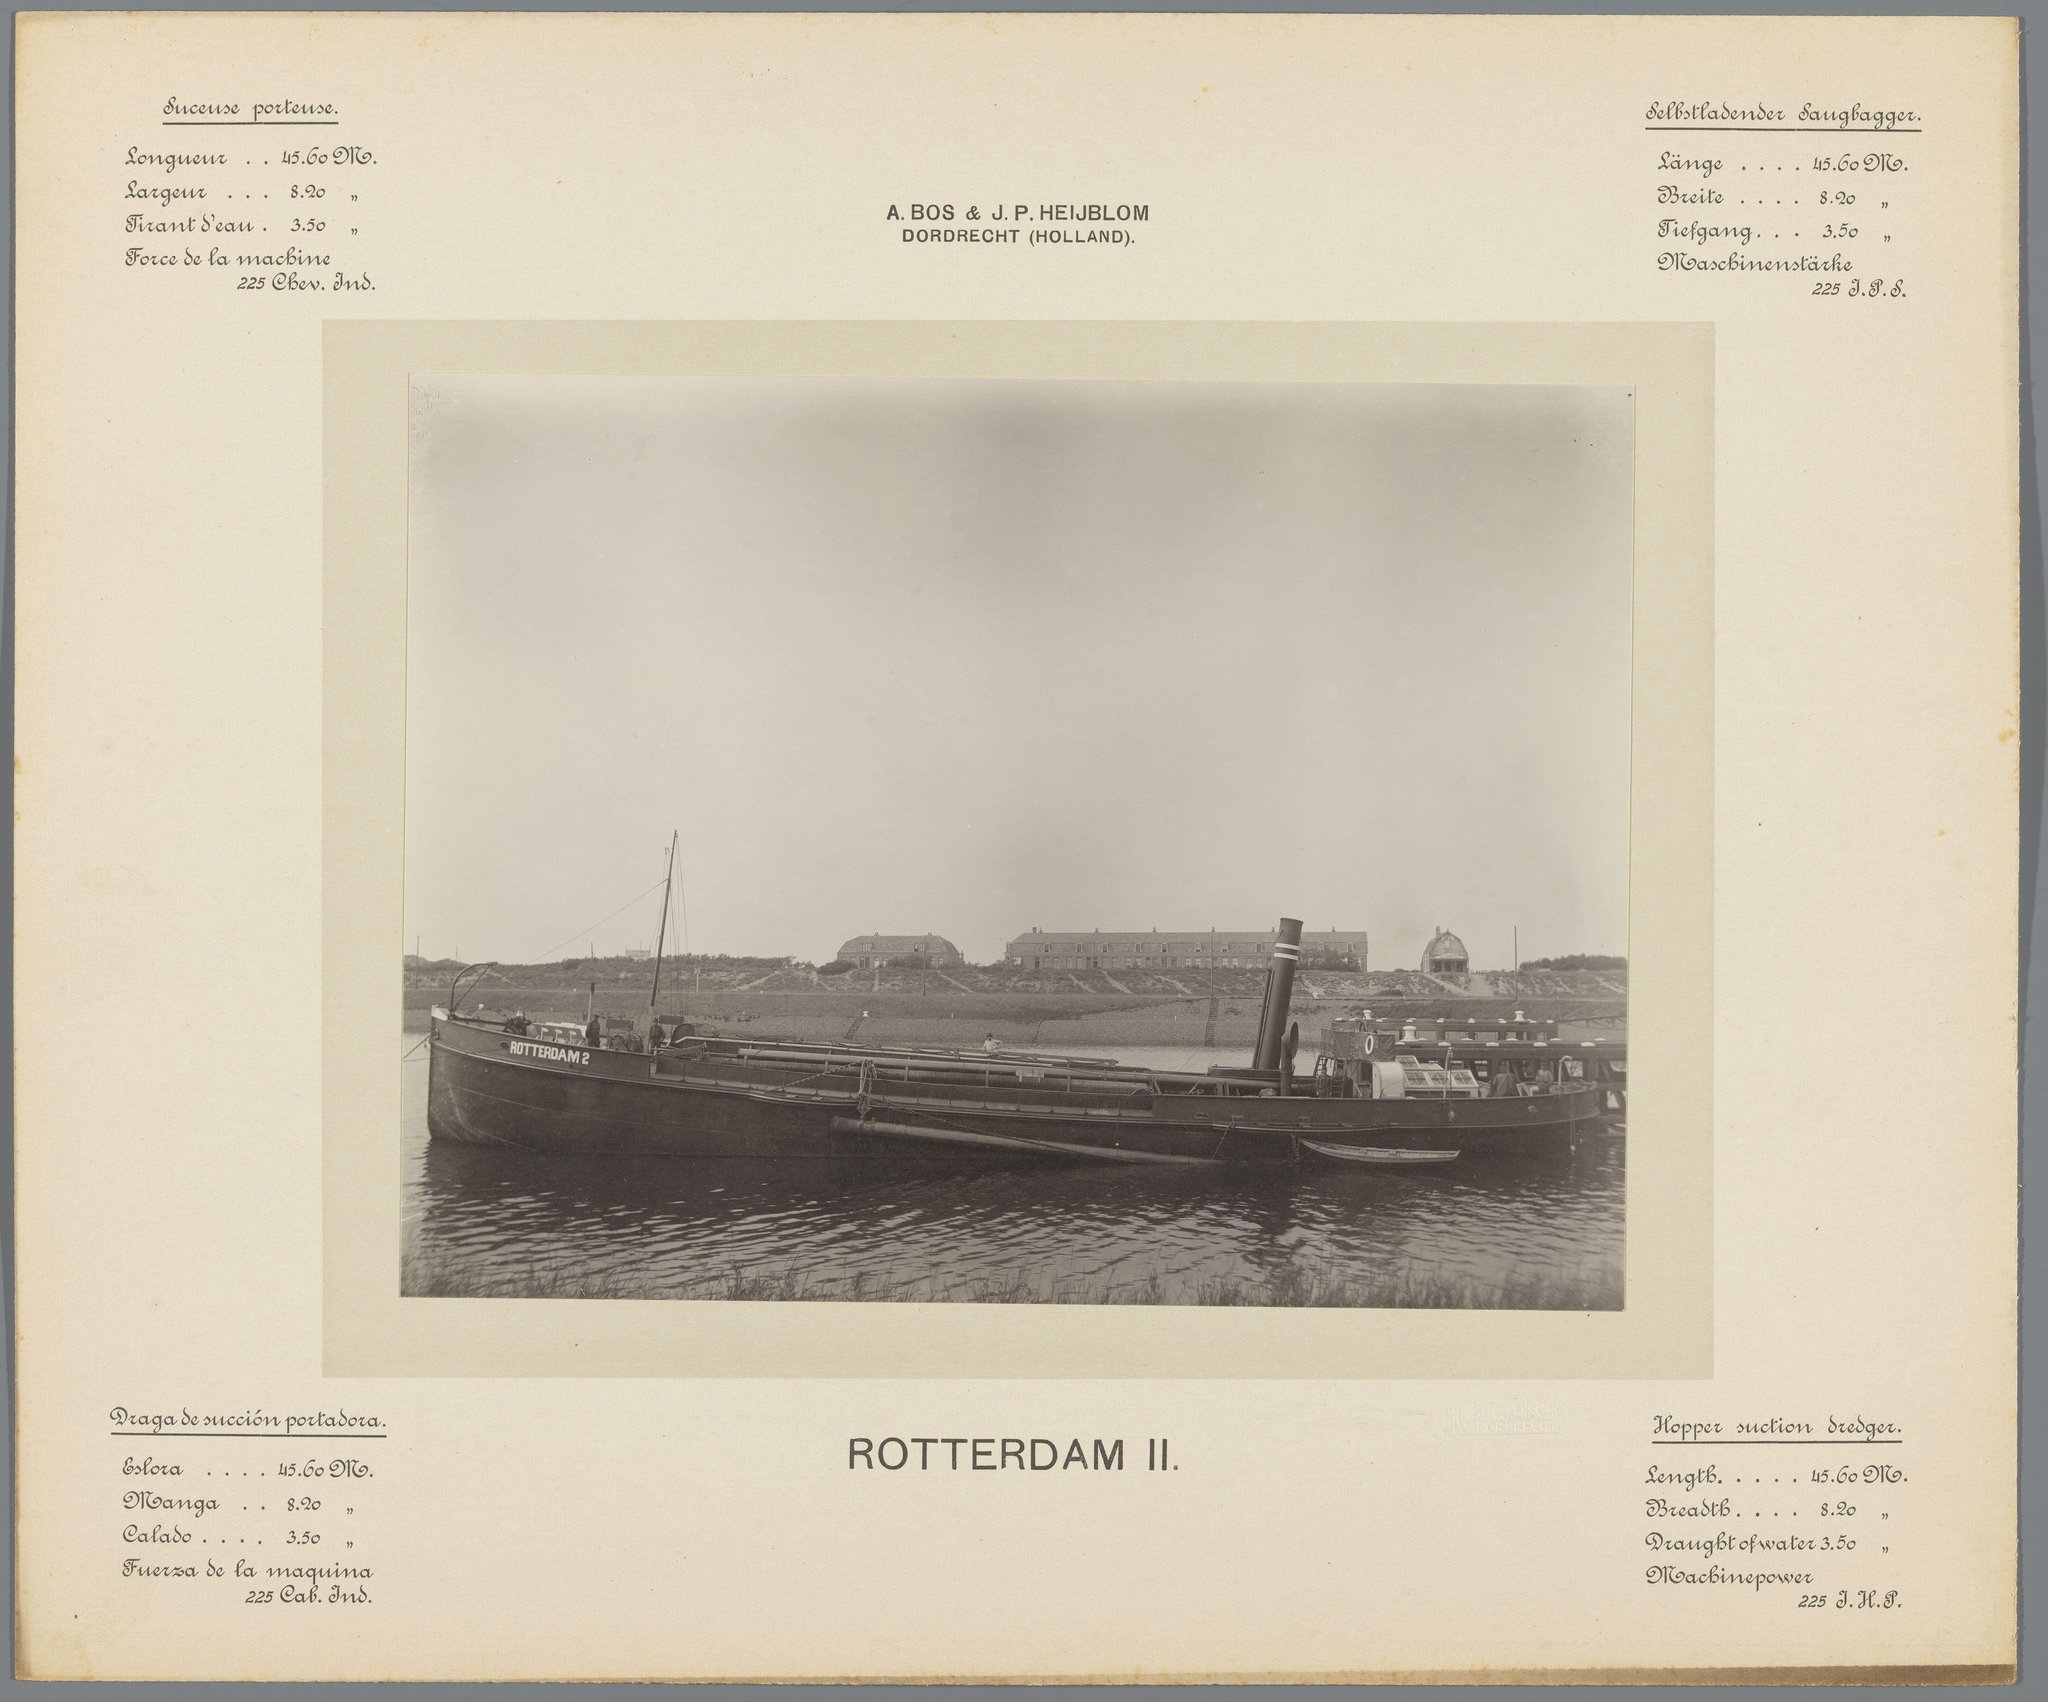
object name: photograph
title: Rotterdam II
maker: henricus jacobus tollens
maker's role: painter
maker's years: 1864-1936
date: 1900-1910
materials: cardboard, photographic support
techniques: gelatin silver print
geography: dordrecht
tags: machine driven by steam, steamship, motorship (+ propulsion of vehicle, ship, etc. by steam), dredge, dredging machine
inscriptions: name: ‘H.J. Tollens C. Hzn. Dordrecht’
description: Hopperzuiger Rotterdam II. Foto geplakt op karton met technische informatie over het schip in Duits, Frans, Spaans en Engels. Onderdeel van de map met 44 foto's van baggerschepen van de firma A. Bos & J.P. Heijblom te Dordrecht.